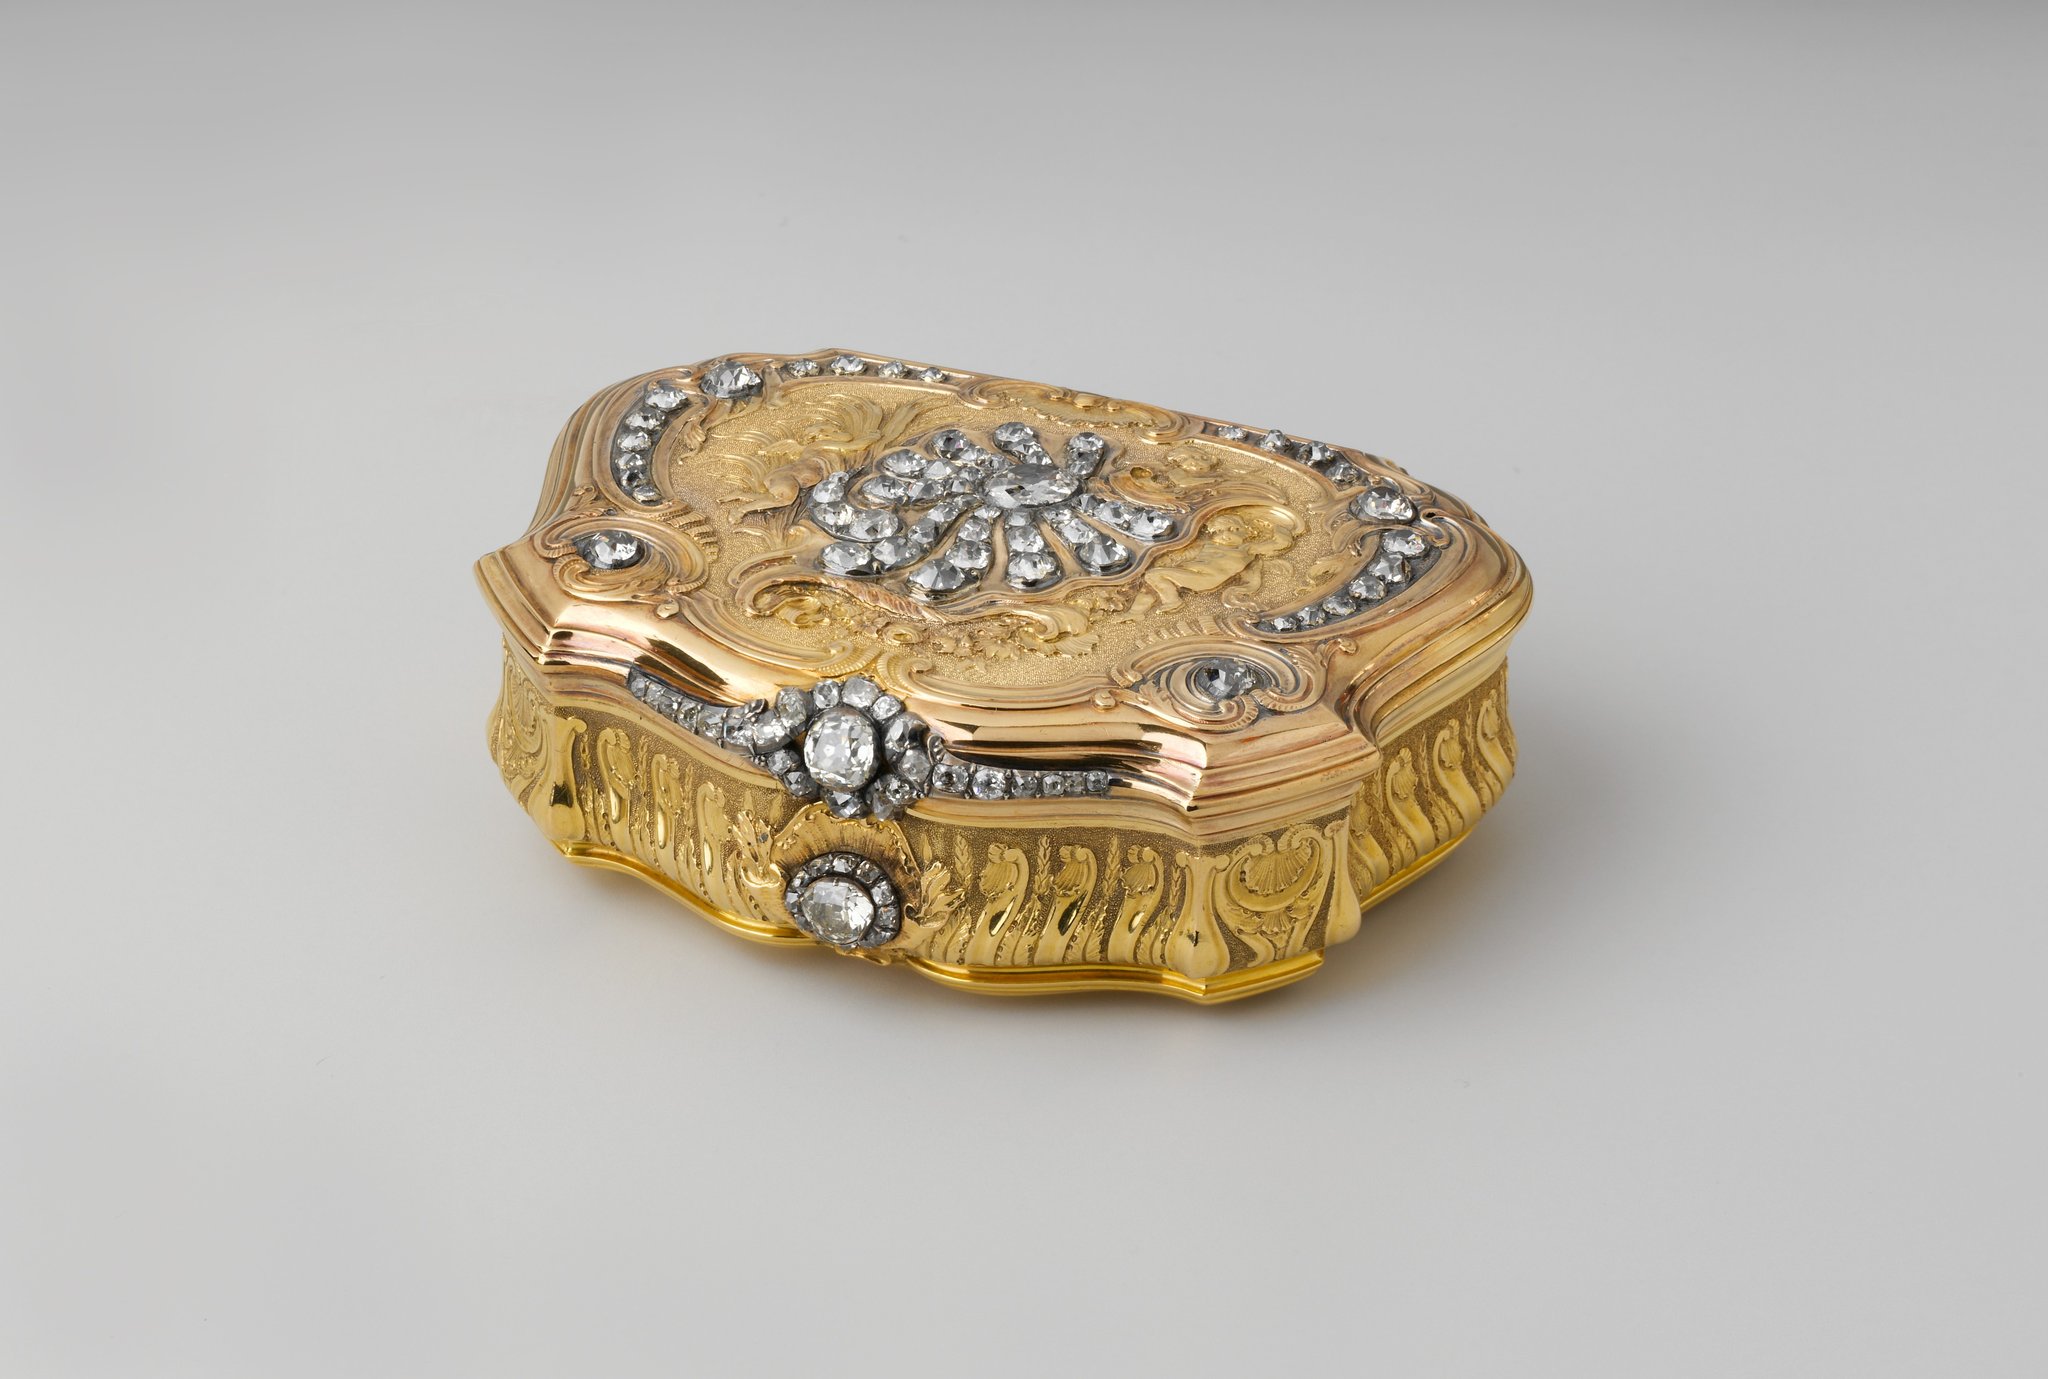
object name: snuffbox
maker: daniel govaers (or gouers)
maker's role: maker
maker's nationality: french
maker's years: 1681-1766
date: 1734-1735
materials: diamond, gold